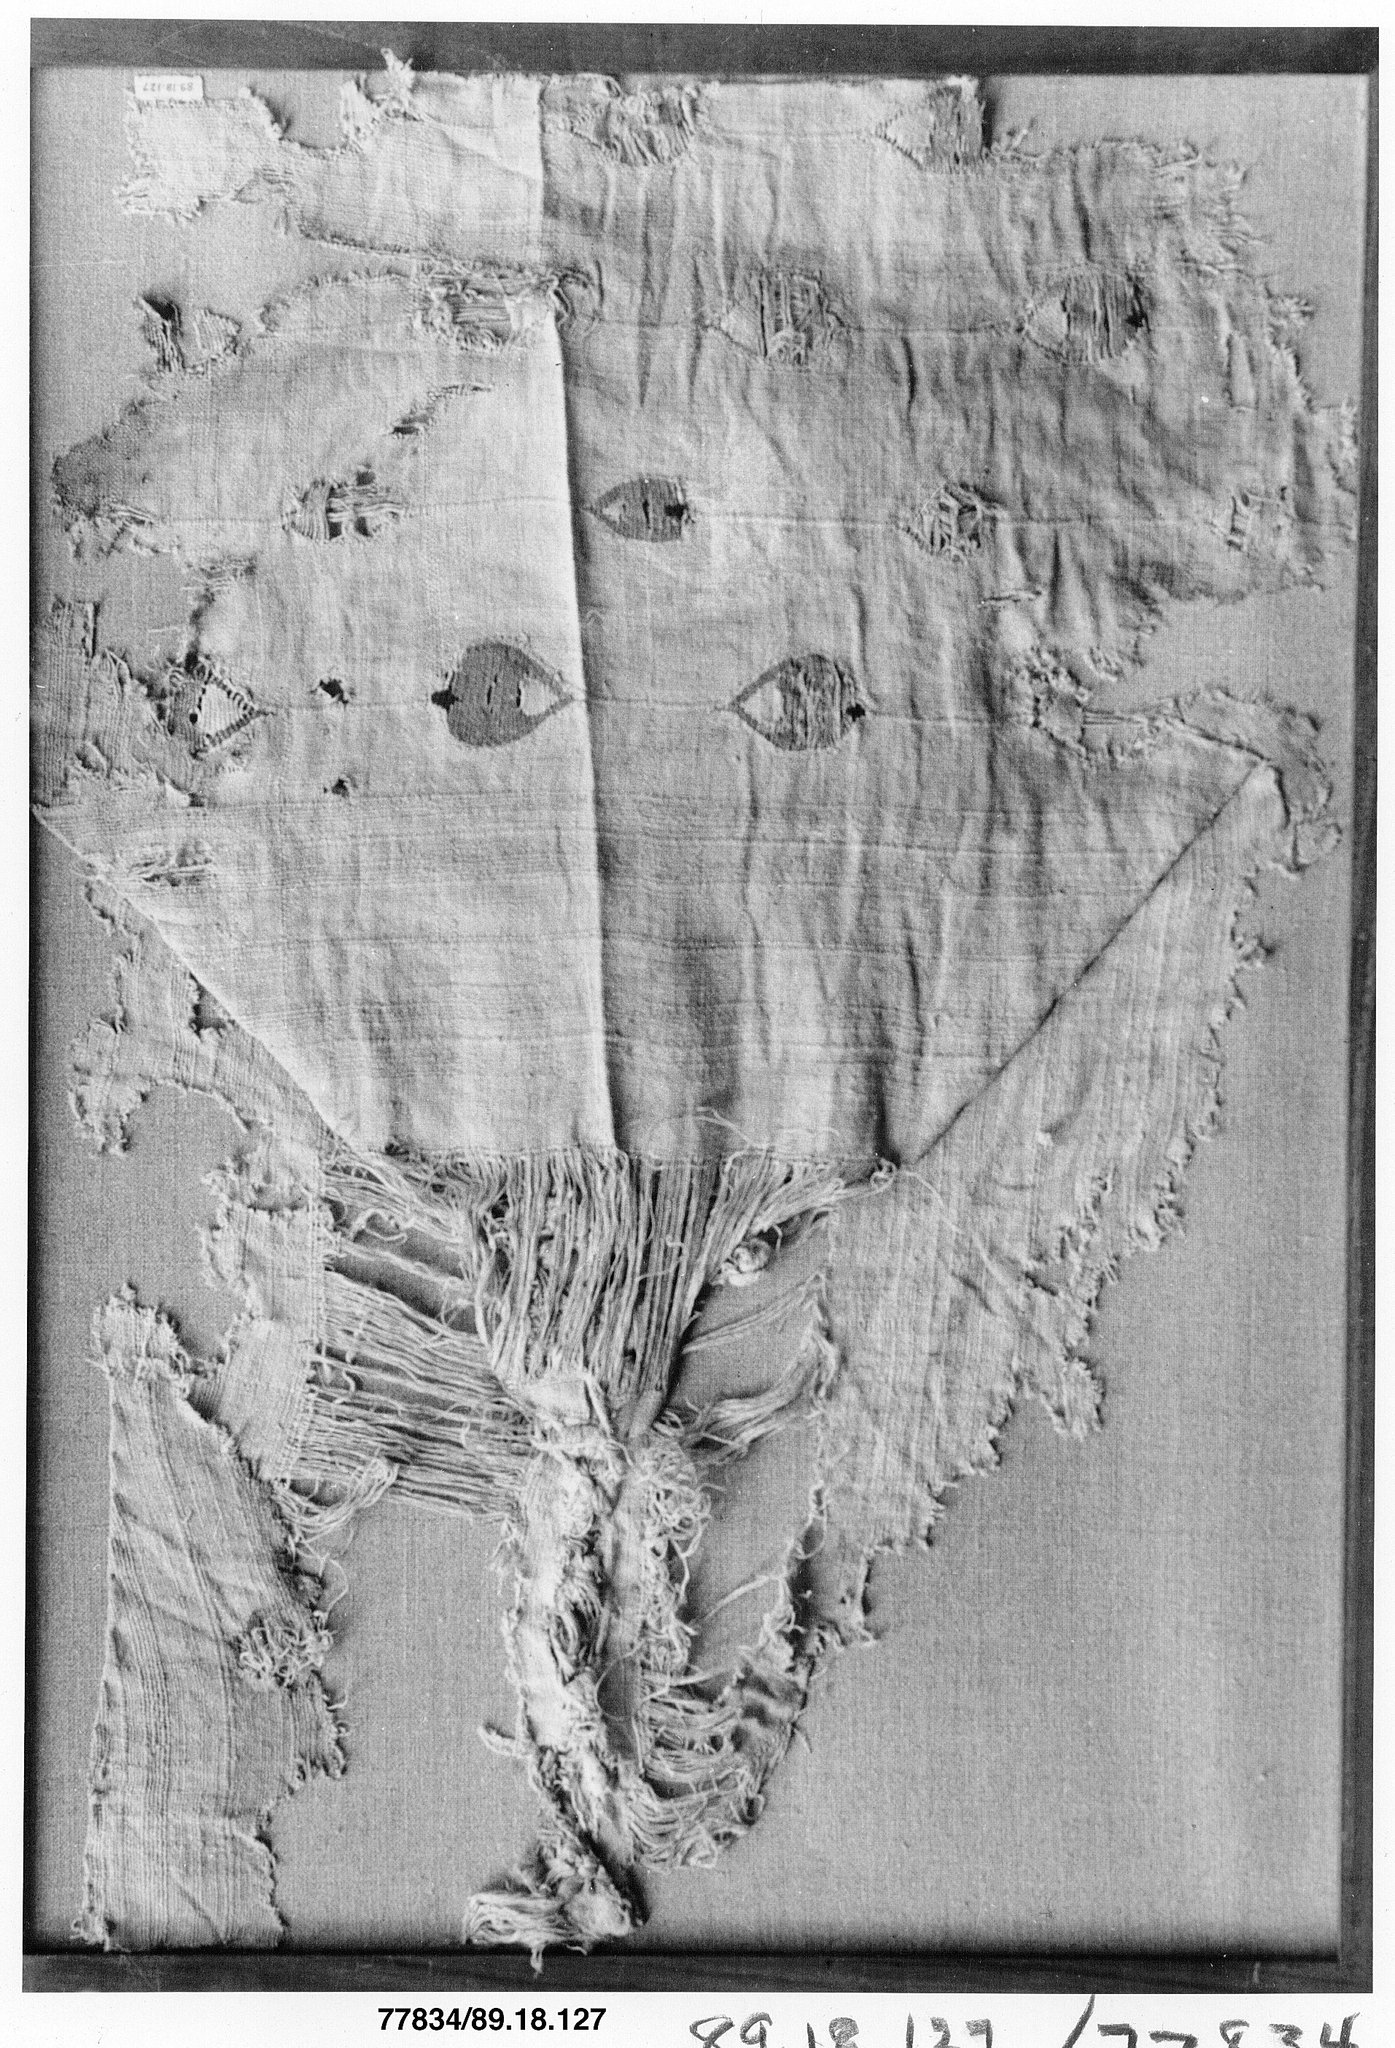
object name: textile fragment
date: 401-600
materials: linen, wool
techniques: weave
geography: egypt